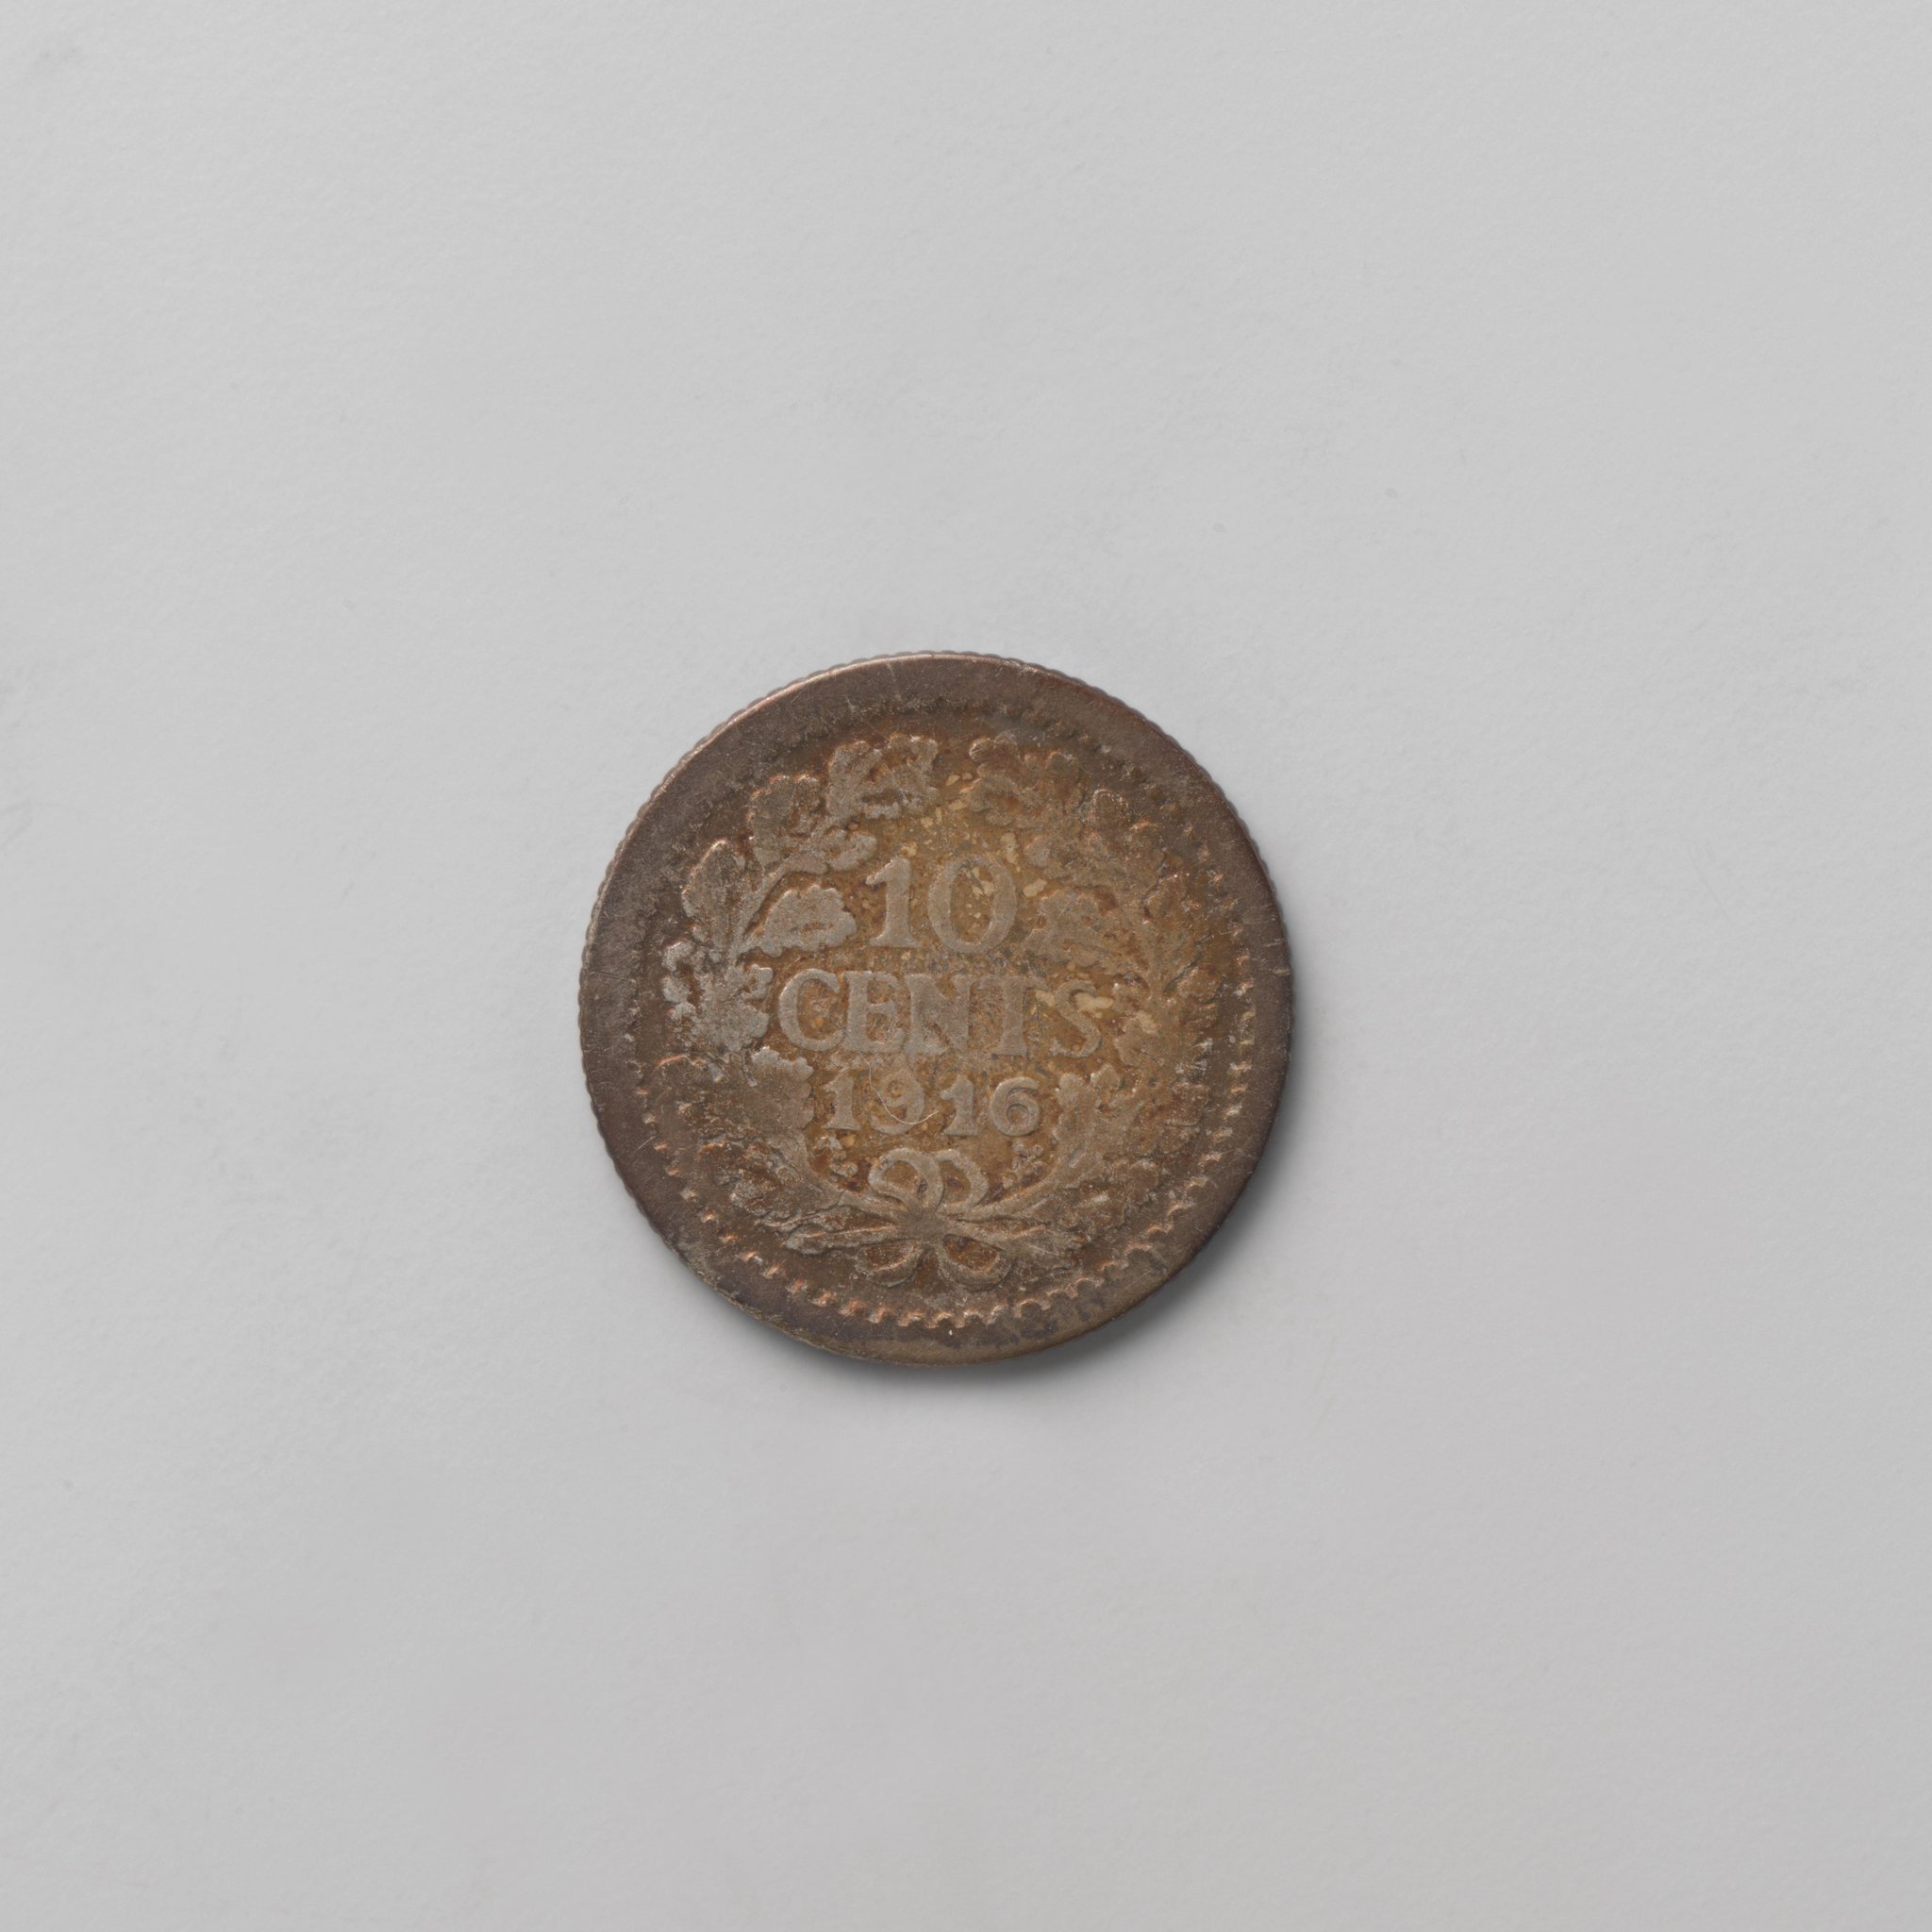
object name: coin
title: Nederlandse10 cent,1916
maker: wilhelmina of the netherlands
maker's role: print maker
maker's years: 1880-1962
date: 1916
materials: silver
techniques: striking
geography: utrecht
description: Zilveren munt. Voorzijde: gedrapeerd borstbeeld naar links. Keerzijde: binnen twee samengebonden eiketakken waarde-aanduiding 10 cents en jaartal. Kartelrand.